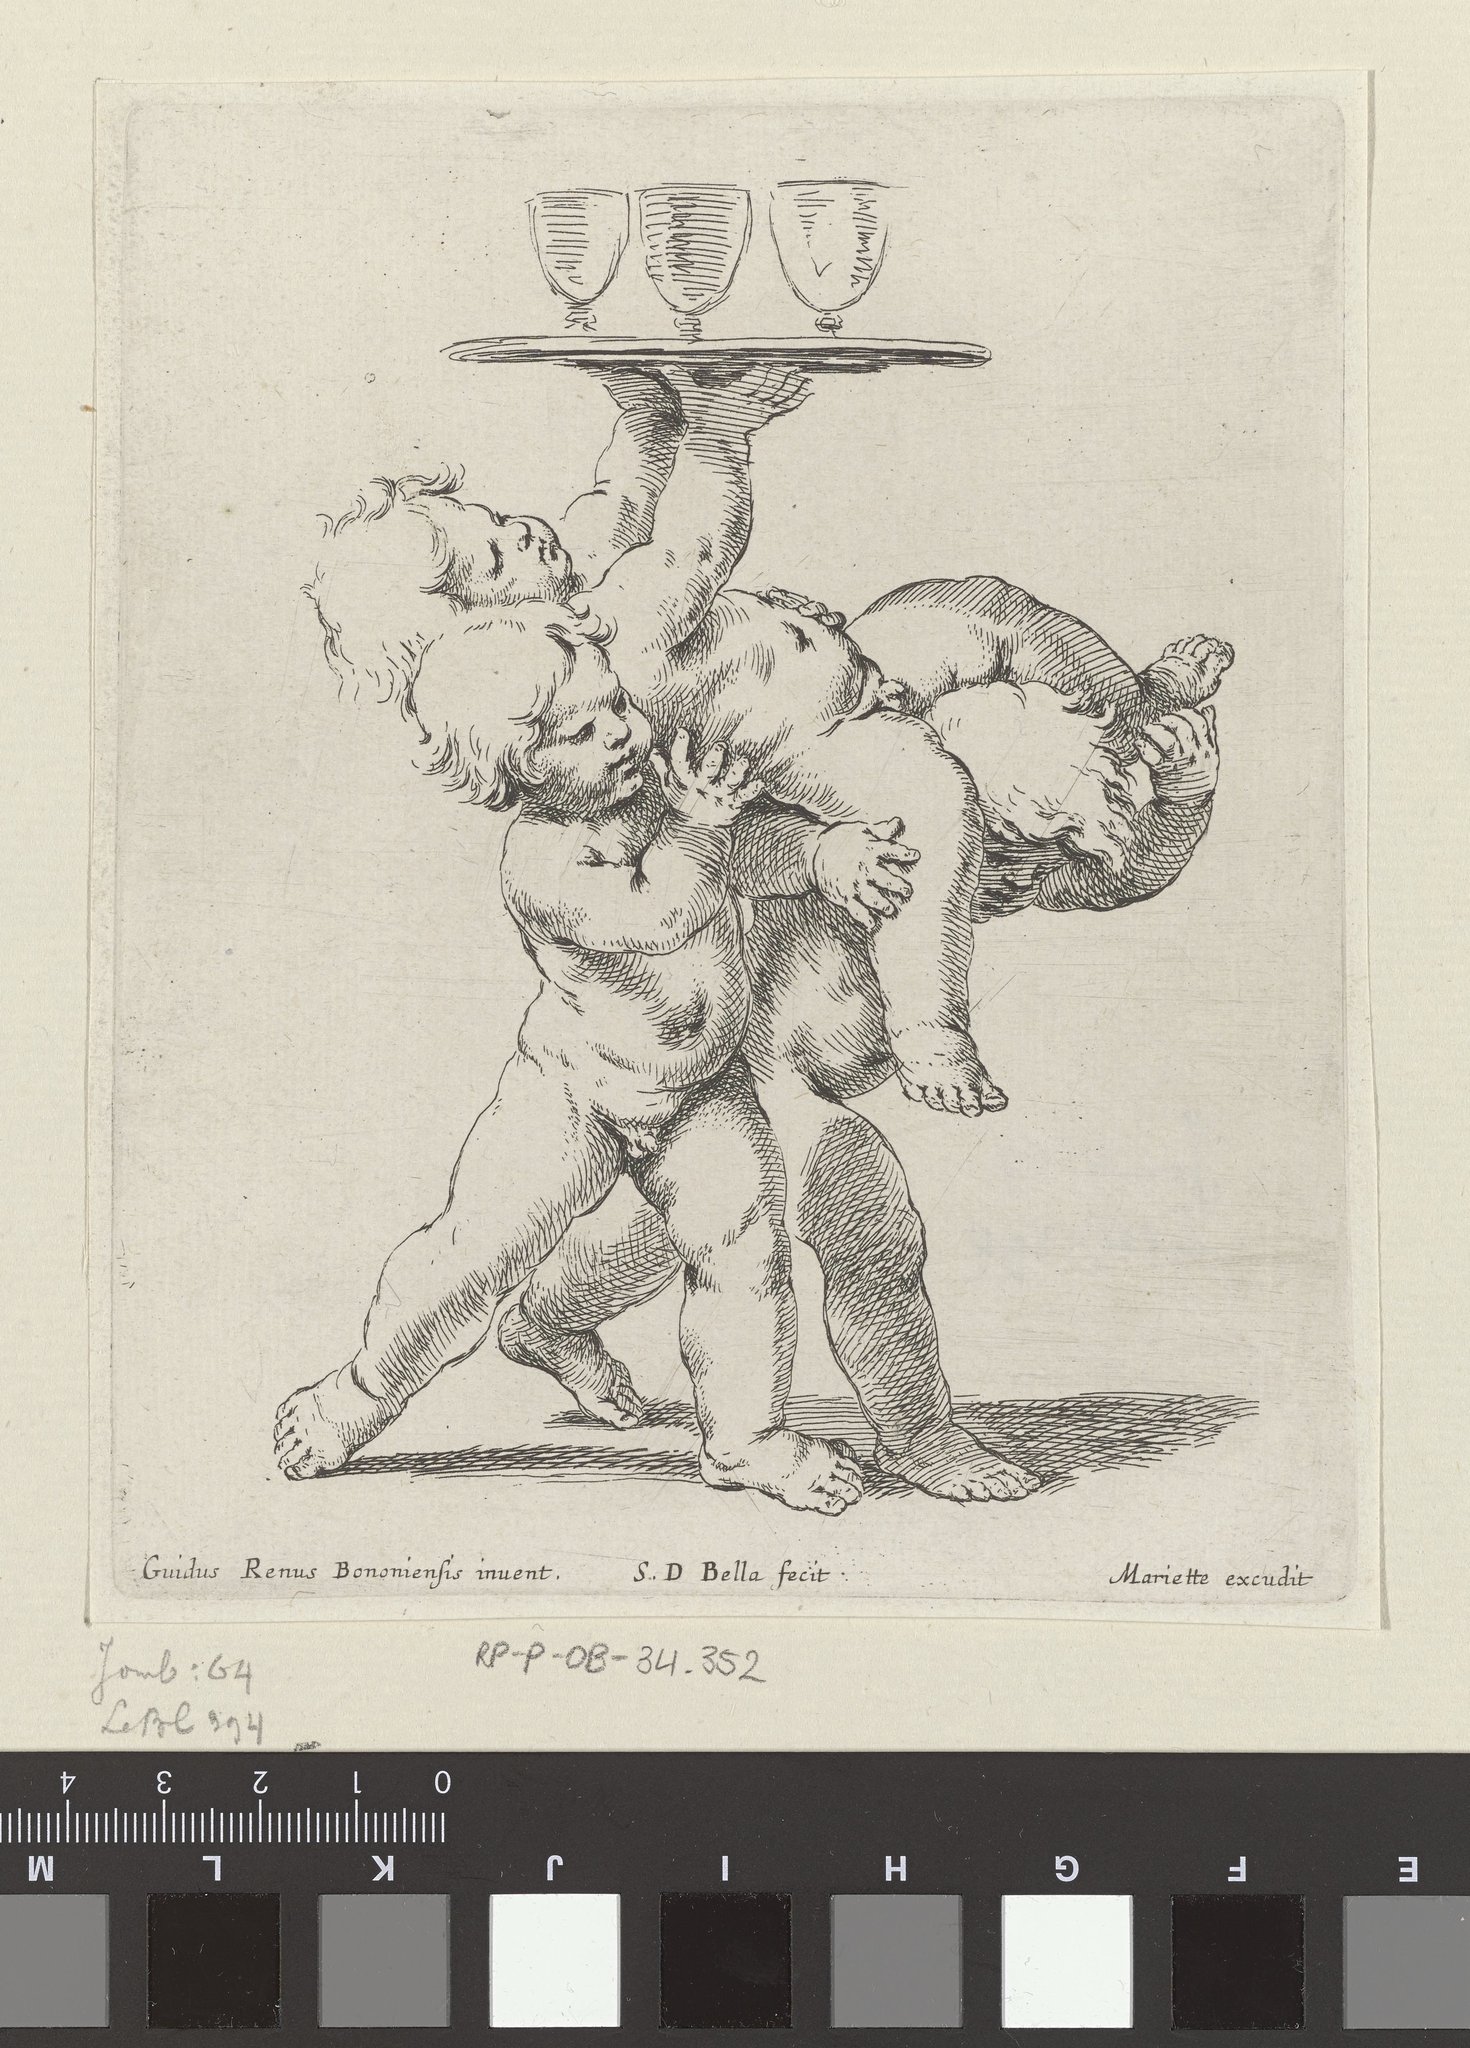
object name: print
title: Drie putti met een dienblad met drie bokalen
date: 1620-1664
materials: paper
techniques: etching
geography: paris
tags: salver, cupids: 'amores', 'amoretti', 'putti'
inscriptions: collector's mark: Lugt 240